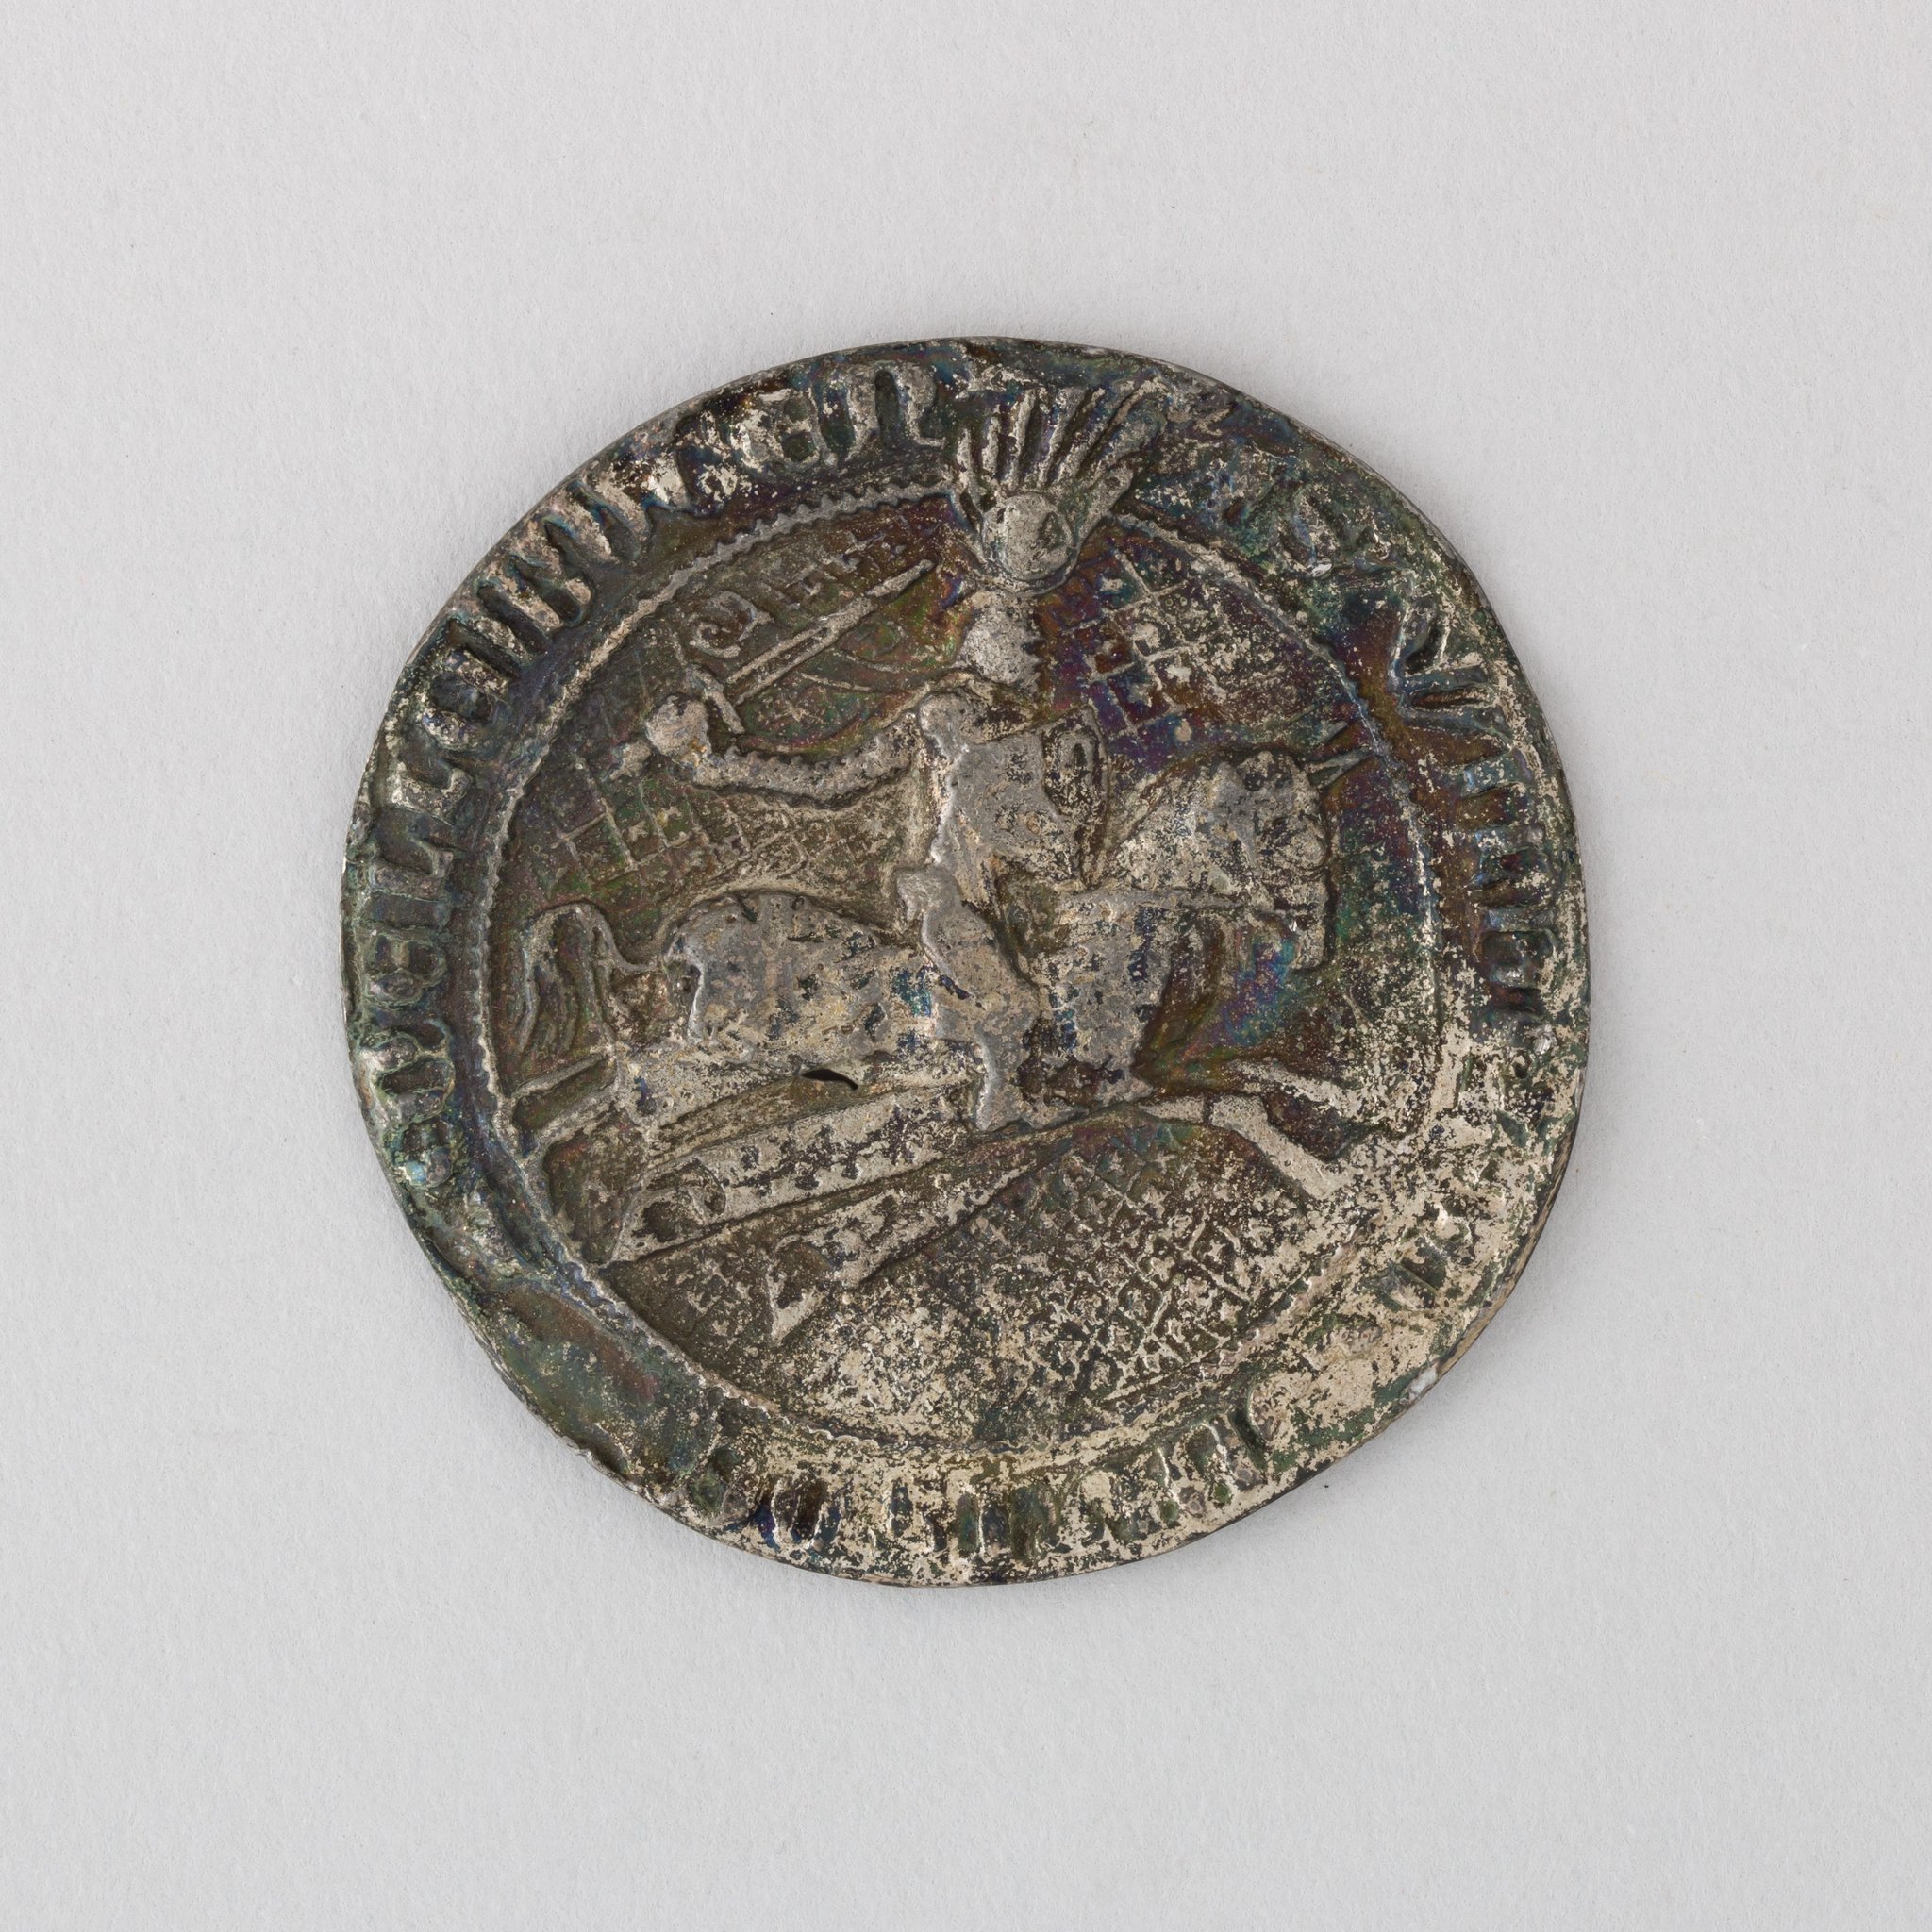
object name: seal reproduction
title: Reproduction of the Seal of Wilhelm, Graf von Catzenelnbogen, L. 12th–14th century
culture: german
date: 1167-1400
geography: germany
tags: horses